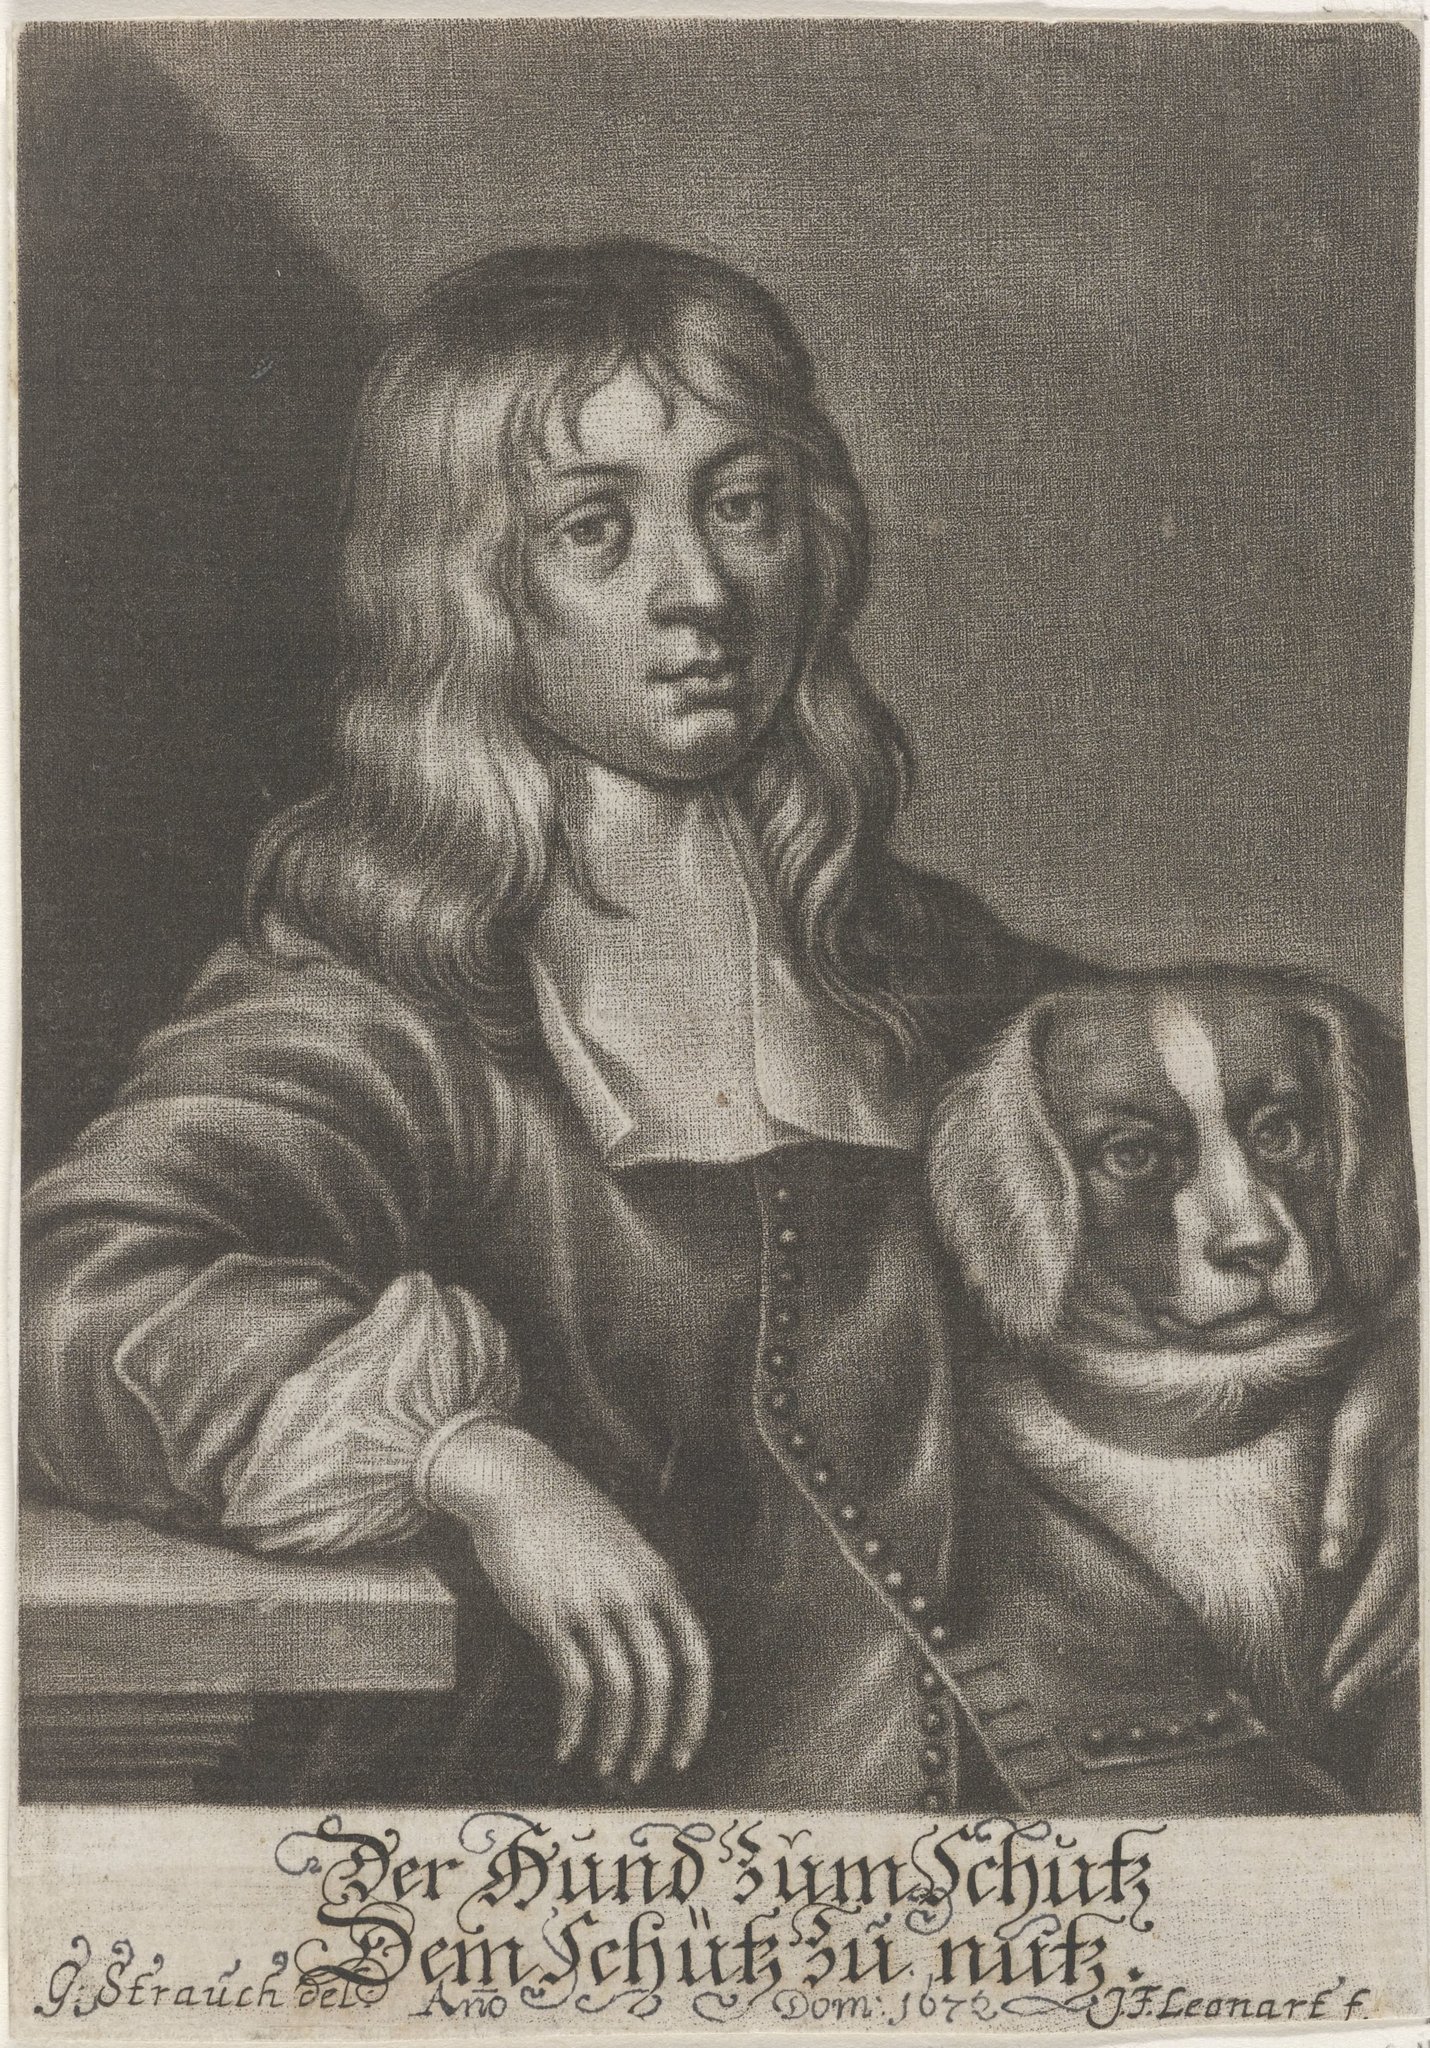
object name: print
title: Portret van Joh. Baltas. Schütz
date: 1672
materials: paper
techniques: engraving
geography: vienna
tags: dog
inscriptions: date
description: De jonge Joh. Baltas. Schütz leunt met zijn arm op een tafel en houdt onder de andere arm een hond.